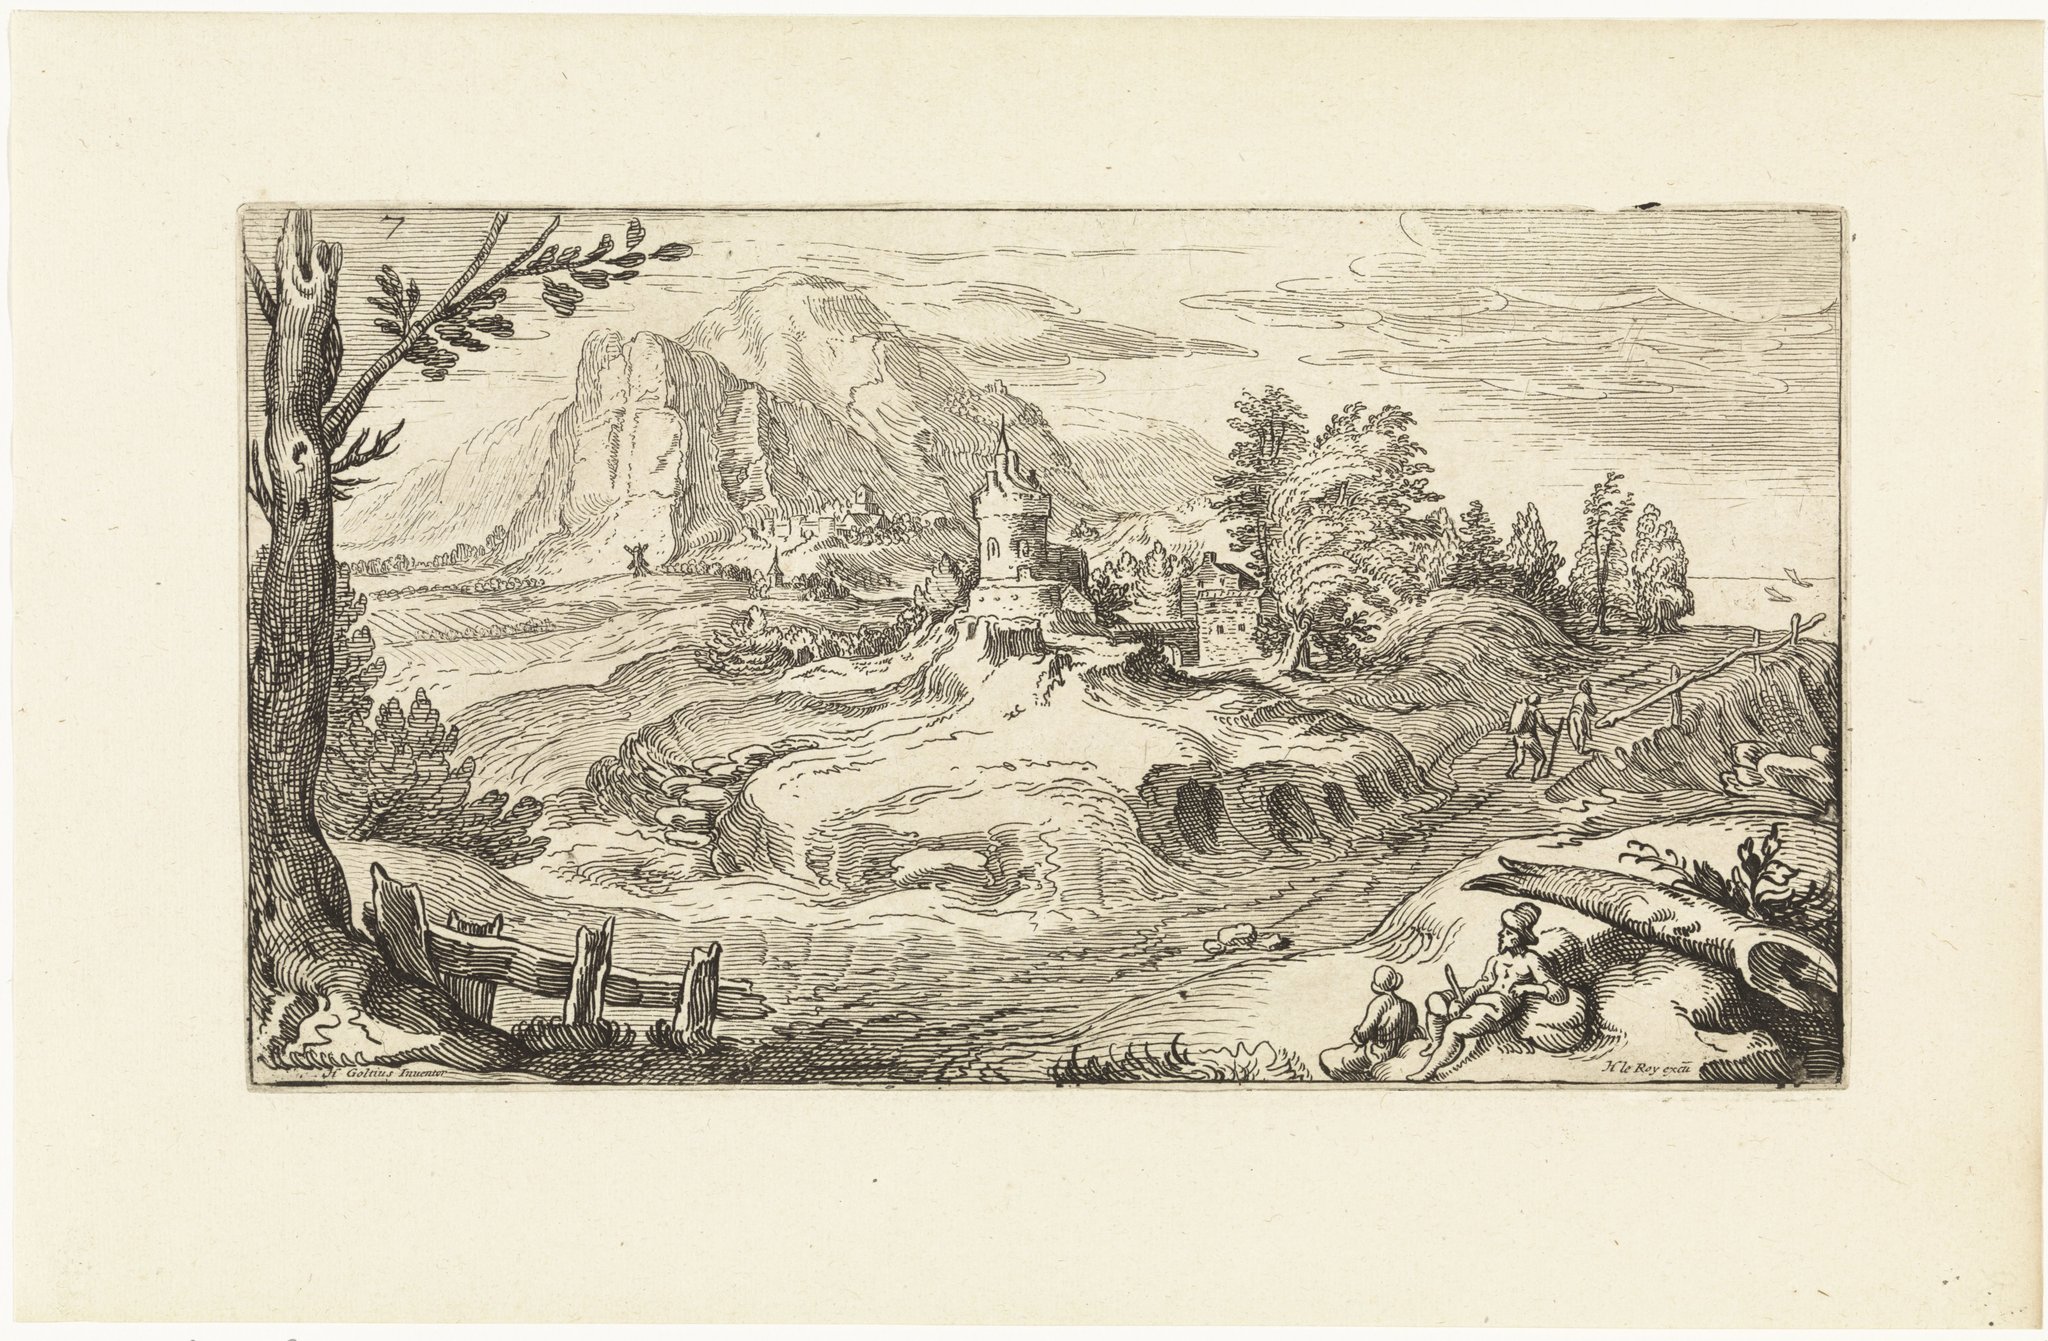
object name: print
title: Landschappen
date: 1602-1649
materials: paper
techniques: etching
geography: amsterdam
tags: landscape with tower or castle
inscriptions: collector's mark: Lugt 2228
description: Een rustende man en vrouw kijken uit over een berglandschap met een kasteel. Op de achtergrond een molen en een dorpje.